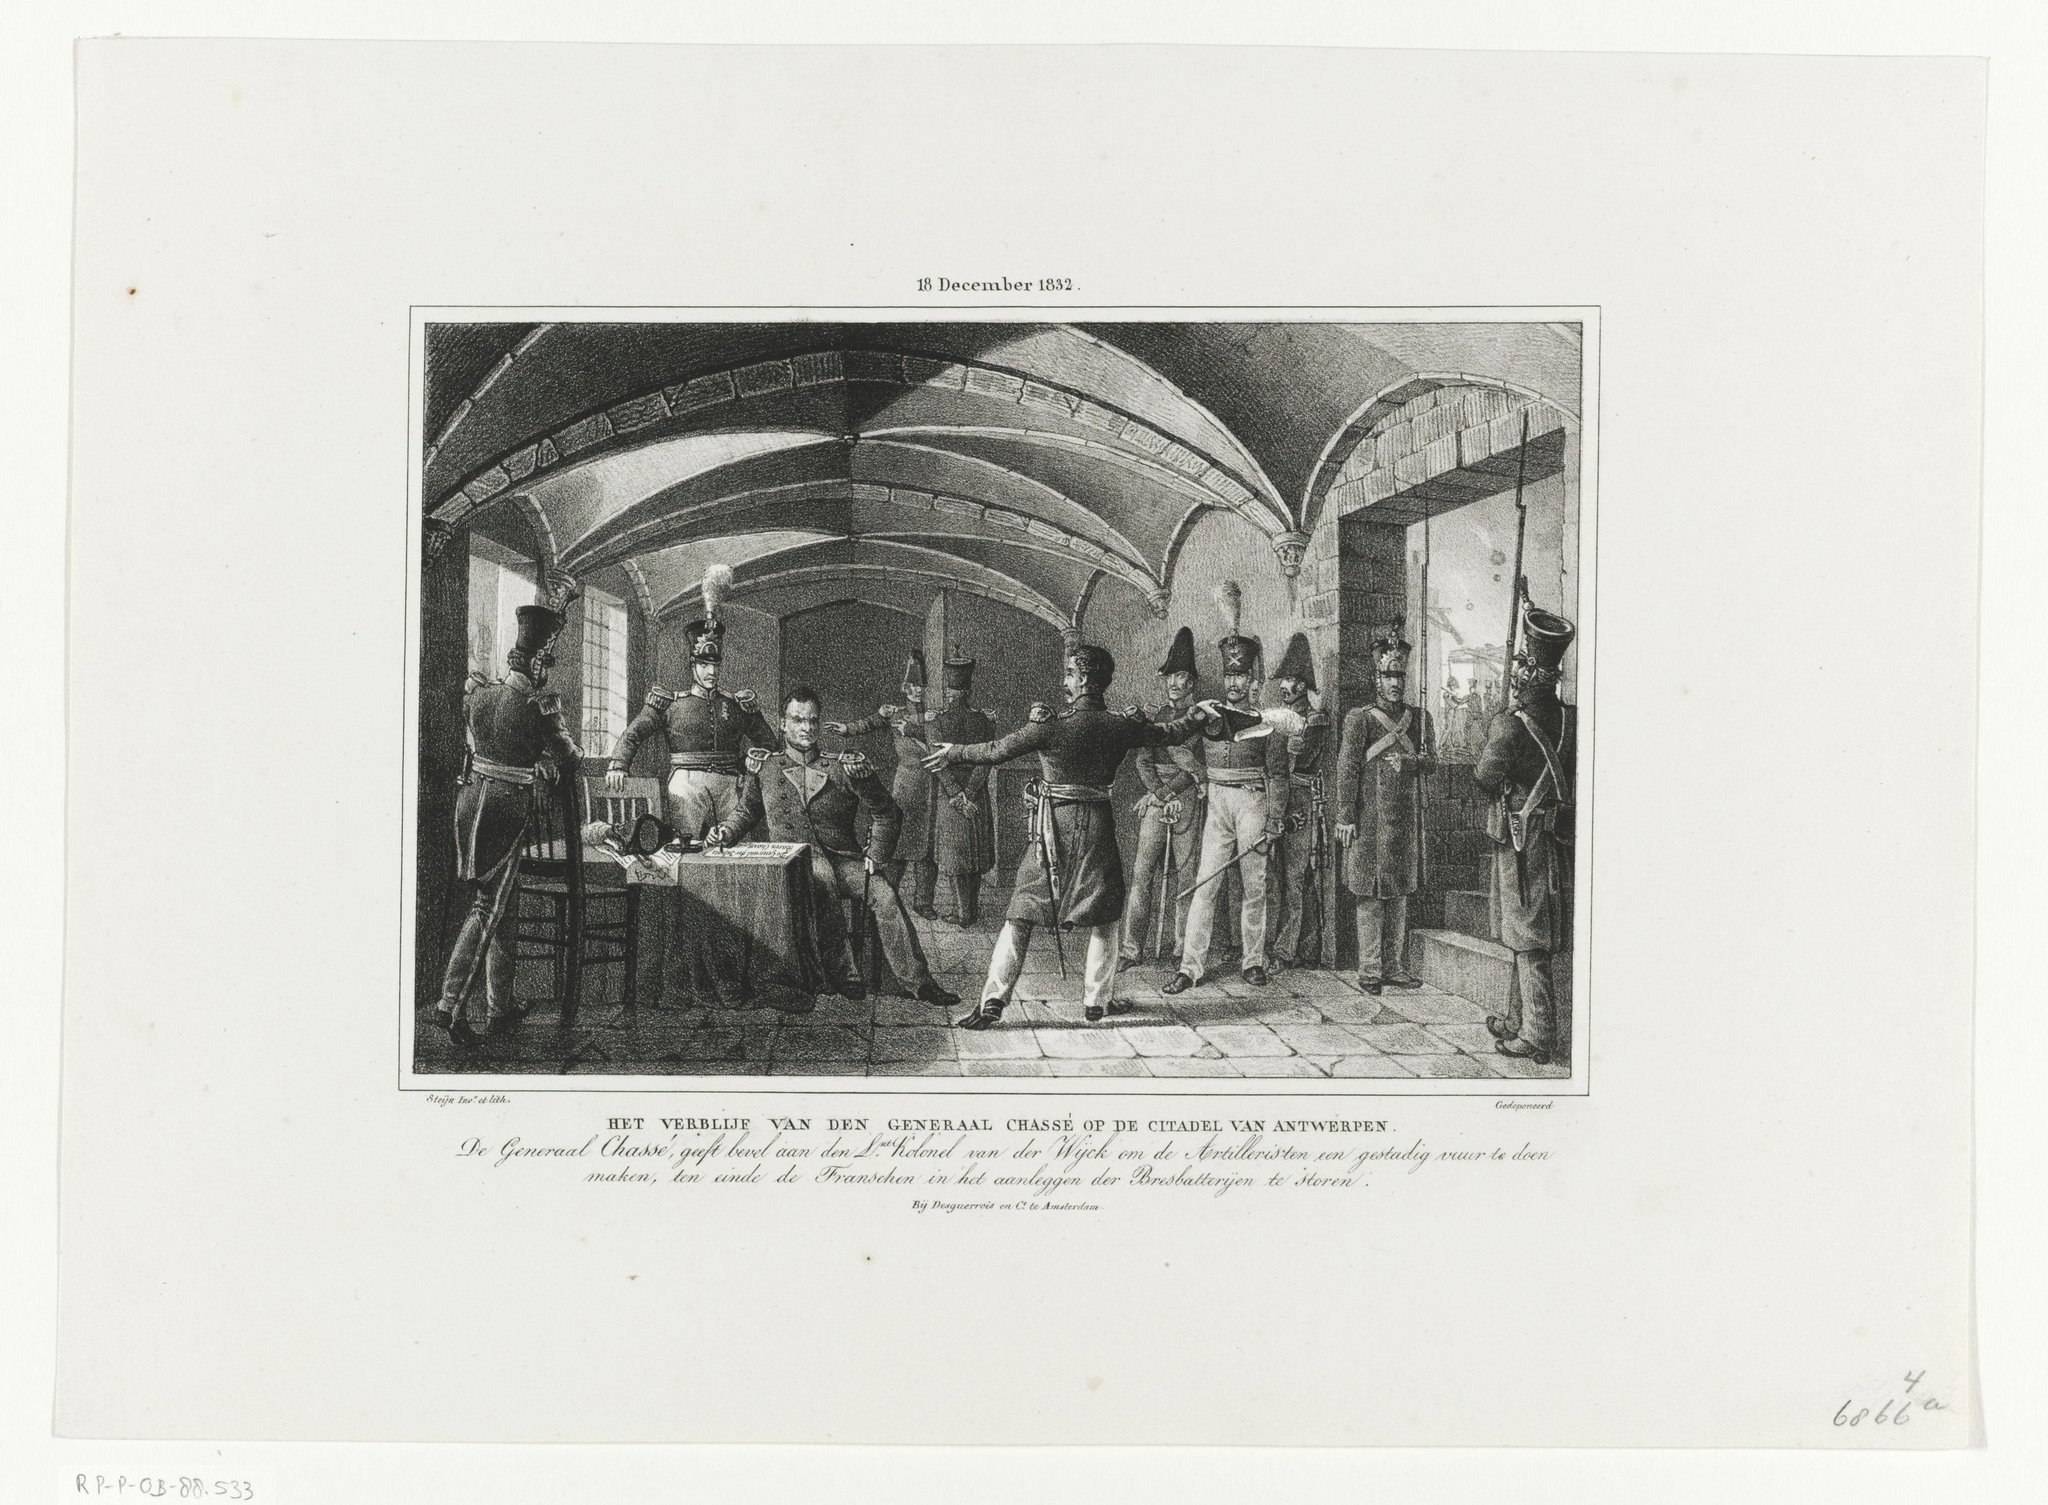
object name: print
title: Vier platen van de verdediging van de Citadel 10-18 december 1832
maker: johannes steyn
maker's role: print maker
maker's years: 1805-1840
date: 1832-1833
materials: paper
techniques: lithograph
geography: netherlands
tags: david hendrik baron chassé, fortifications, military engineering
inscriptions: collector's mark: Lugt 2228, : ‘Gedeponeerd’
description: Generaal Chassé in zijn bunker in de Citadel geeft luitenant-kolonel Van der Wijck bevel de Fransen onder artillerievuur te houden, 18 december 1832. Onderdeel van een serie van vier platen van de Nederlandse verdediging tijdens het beleg van de Citadel van Antwerpen door het Franse leger, december 1832.